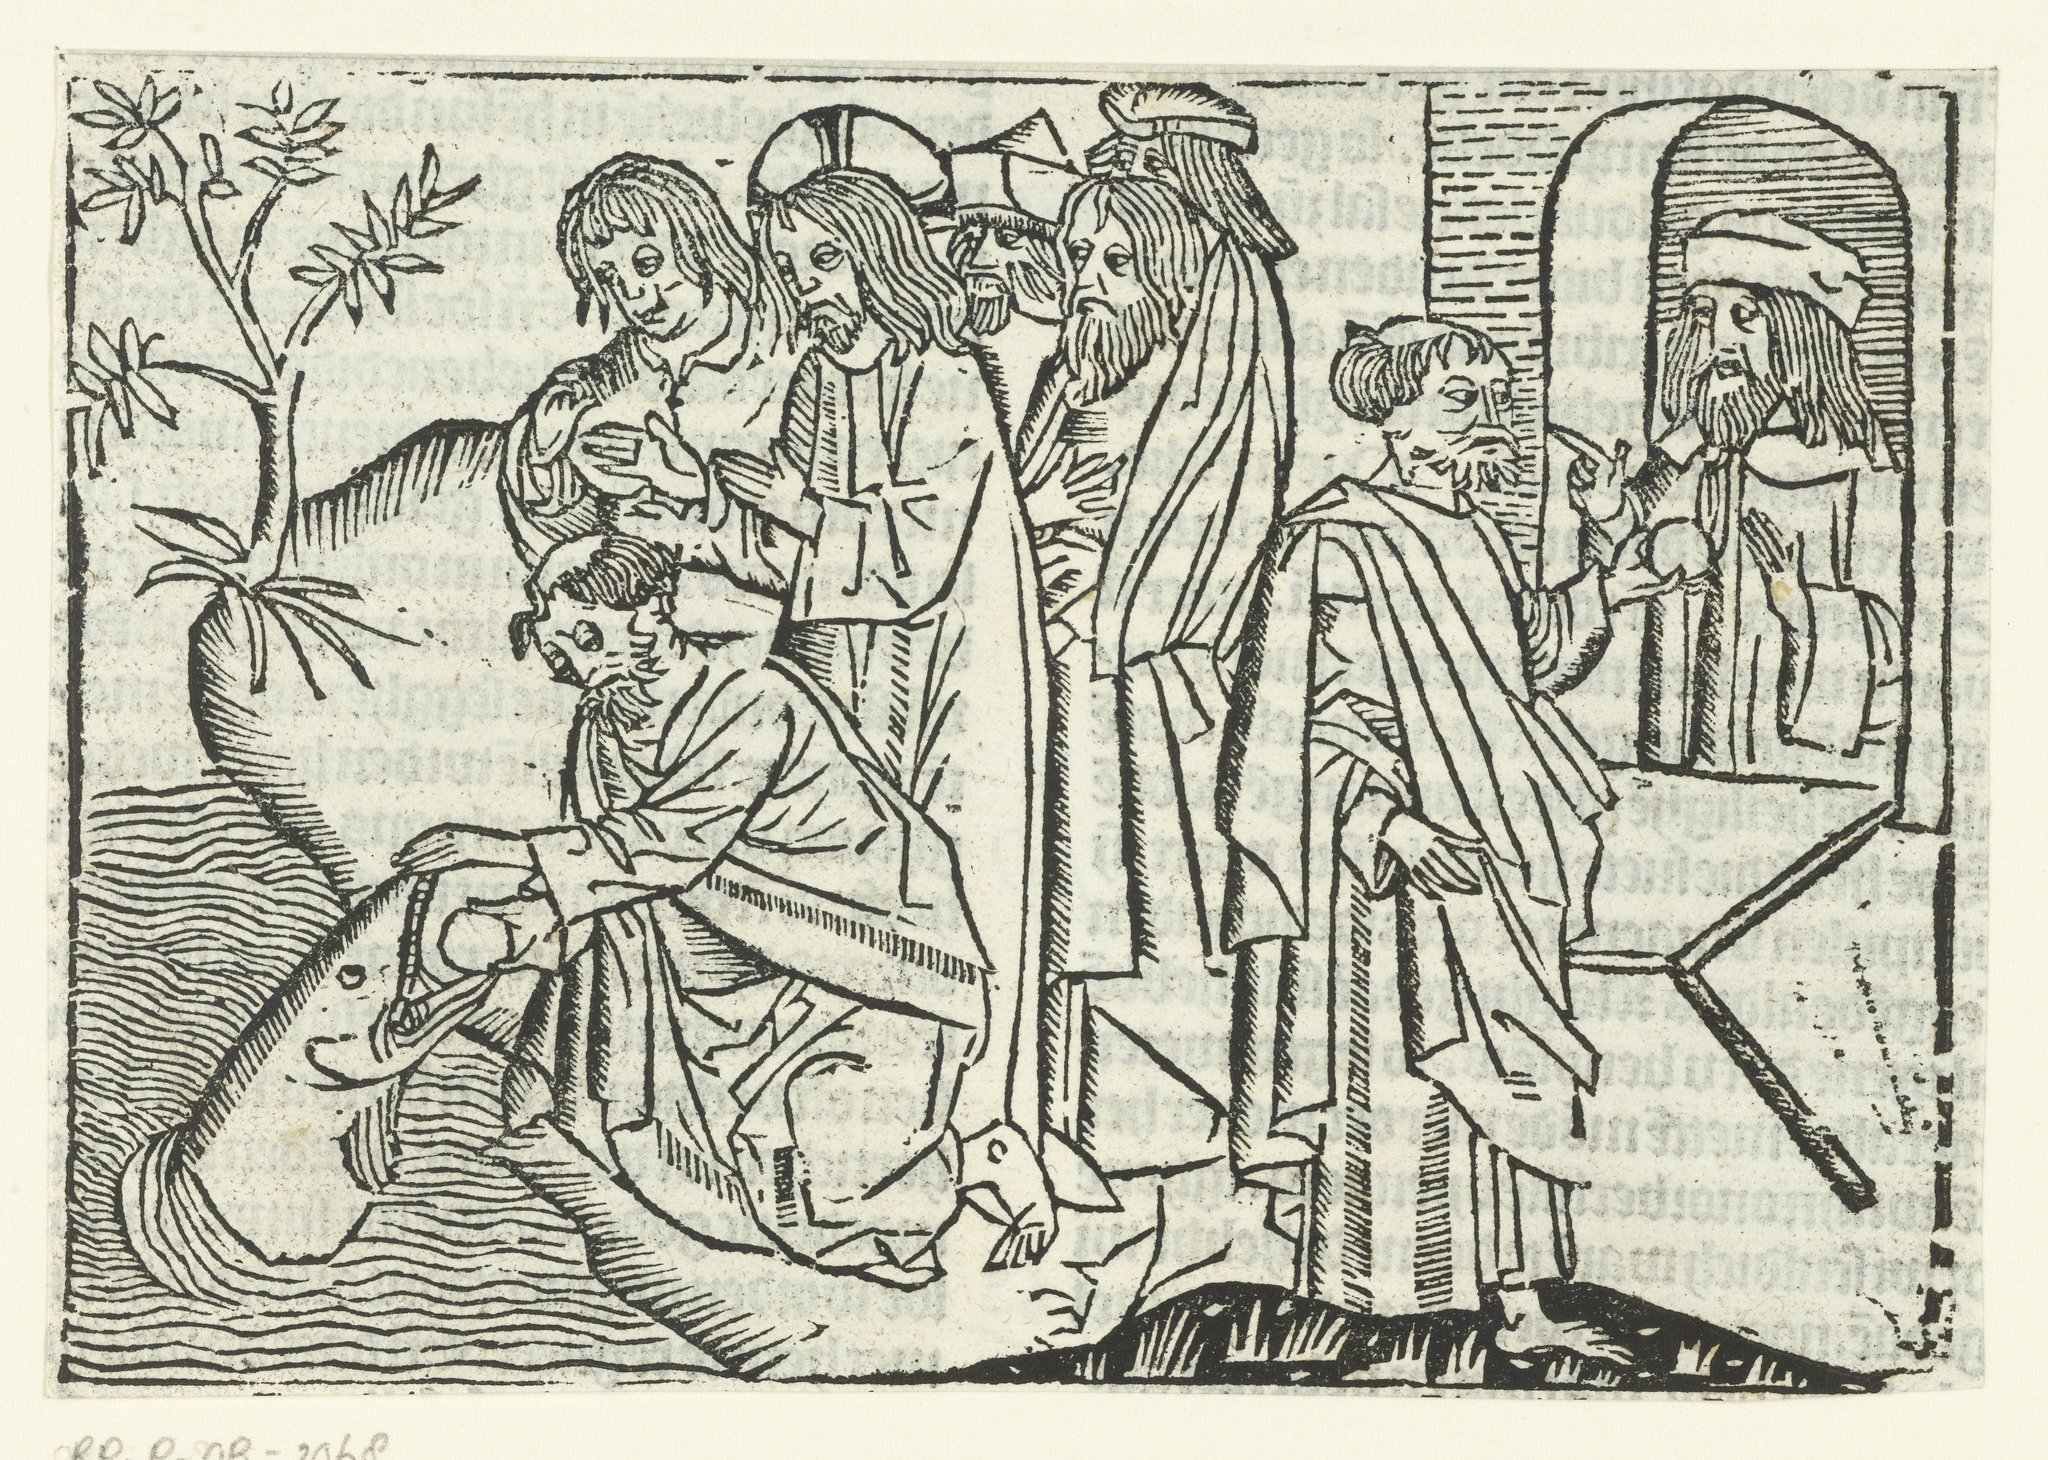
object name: print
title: Petrus en de tempelbelasting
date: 1480-1500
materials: paper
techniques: woodcut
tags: peter finds a piece of money in the mouth of a fish and pays the temple tribute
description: Eén blad van 113 uit Ludolphus de Saxonia, "Dit es dleué ons liefs heeren ihesu christi". Anonieme Nederlandse vertaling. Uitgegeven door Henrick Eckert van Homberch te Antwerpen in 1503. Botke, K. Deze 113 houtsneden, die meestal reeds in vroege Nederlandse boeken gebruikt zijn, worden toegeschreven aan de tweede Meester van Delft, de Meester van de Delbecq-Schreiber-passie en de Meester van de Virgo inter Virgines. In Conway (1884) en in "De gulden passer"(1951) zijn ook eerdere versies opgenomen. Botke, K.